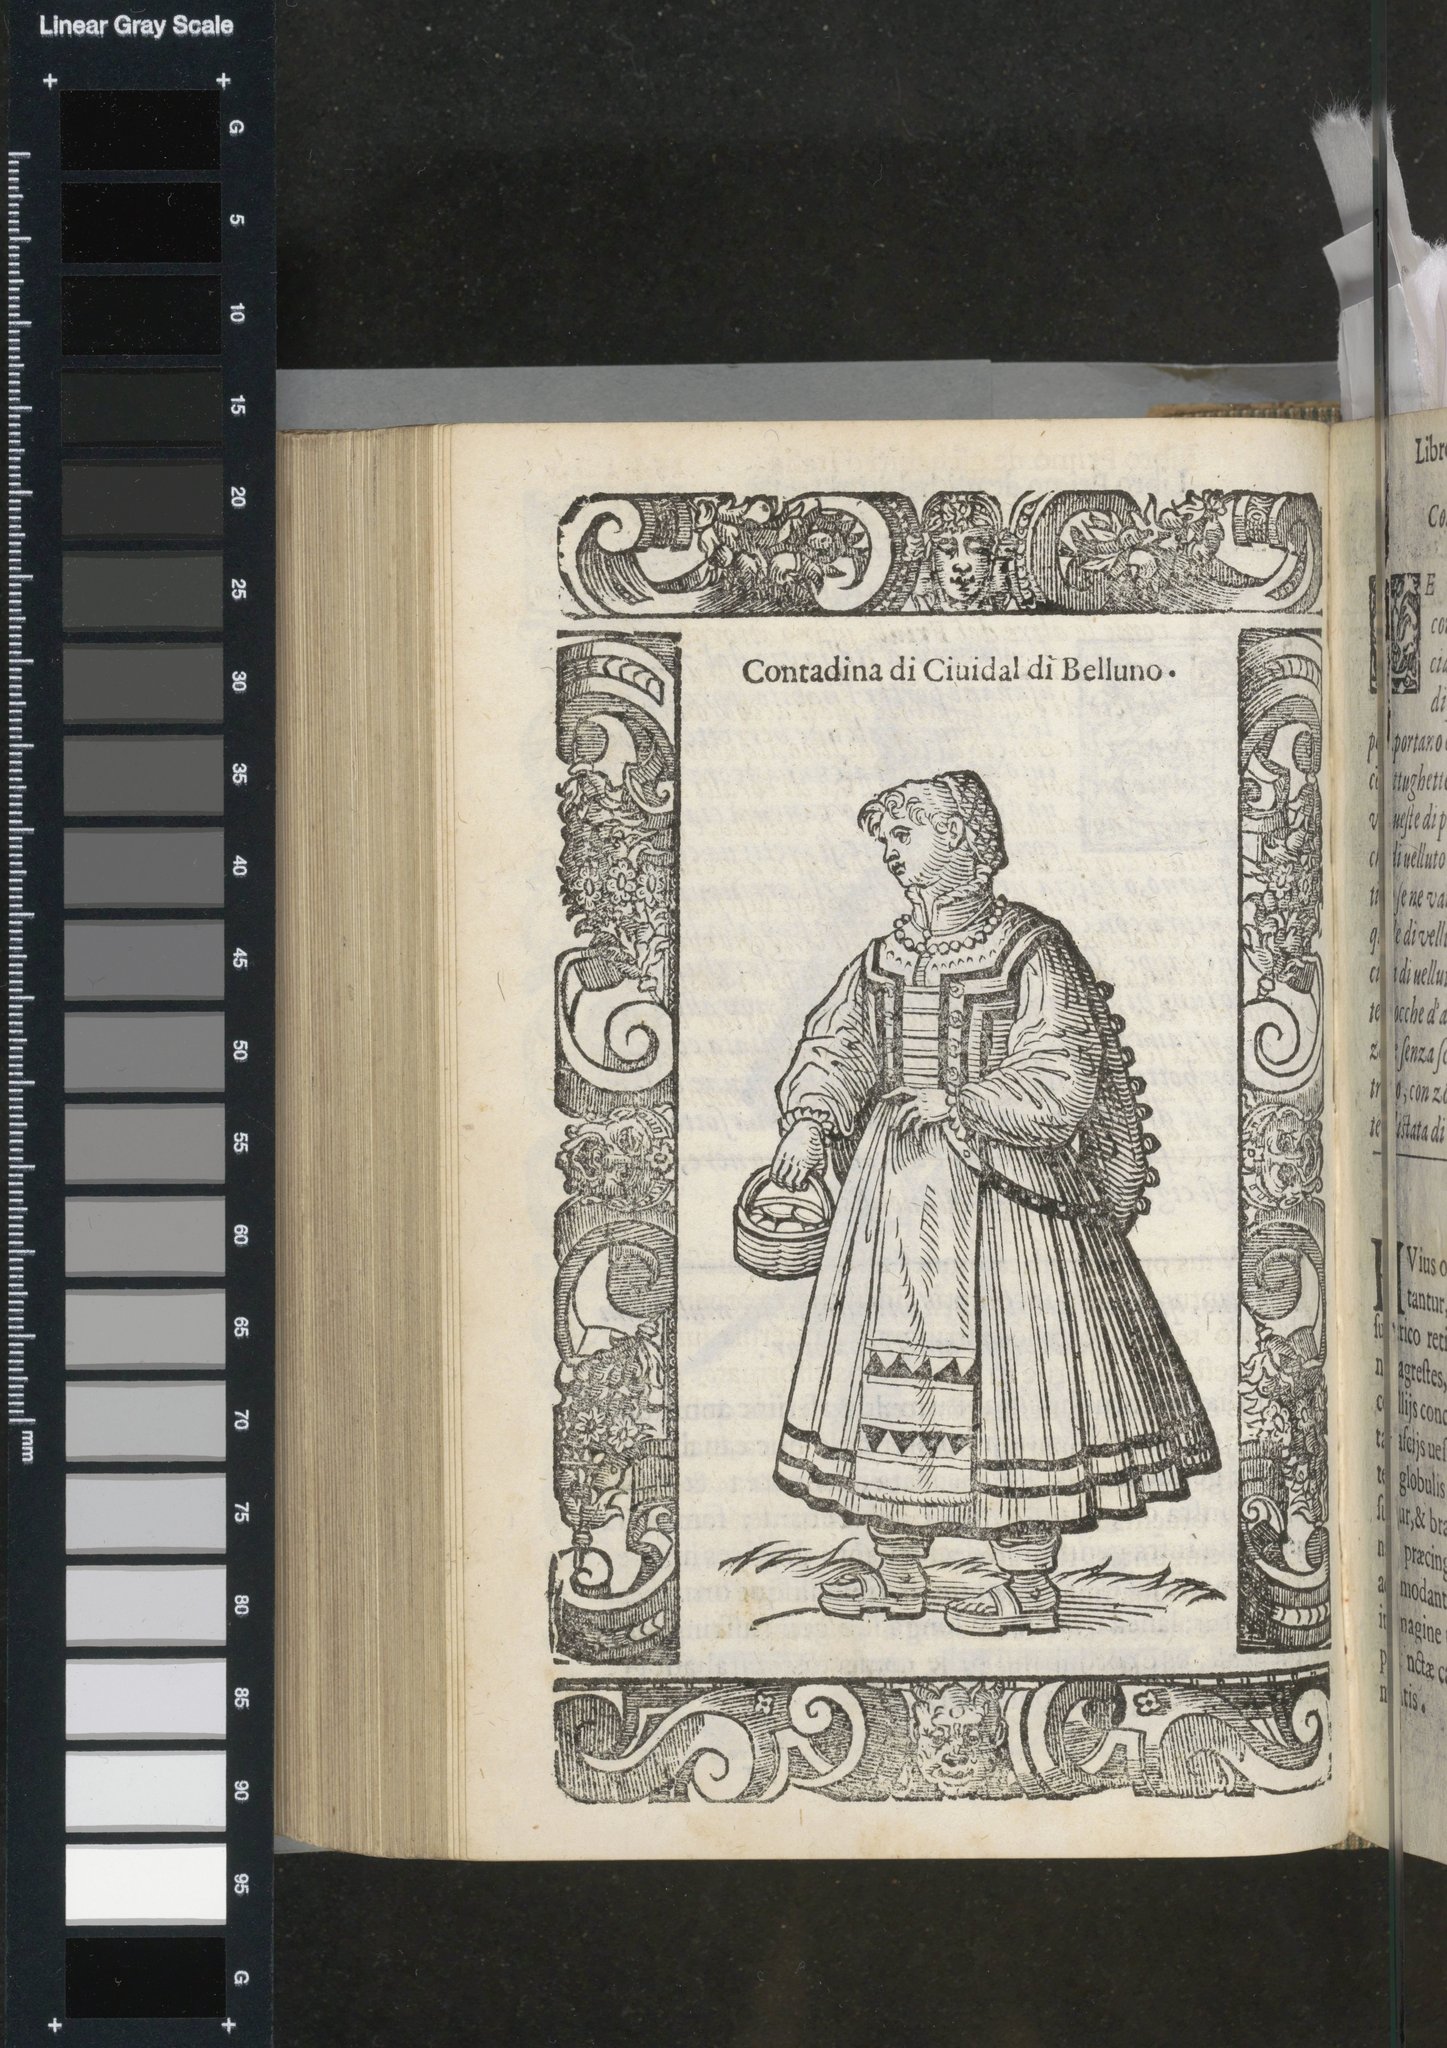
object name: costume print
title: Habiti antichi, et moderni di tutto il mondo...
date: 1598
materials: paper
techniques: woodcut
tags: fashion plates